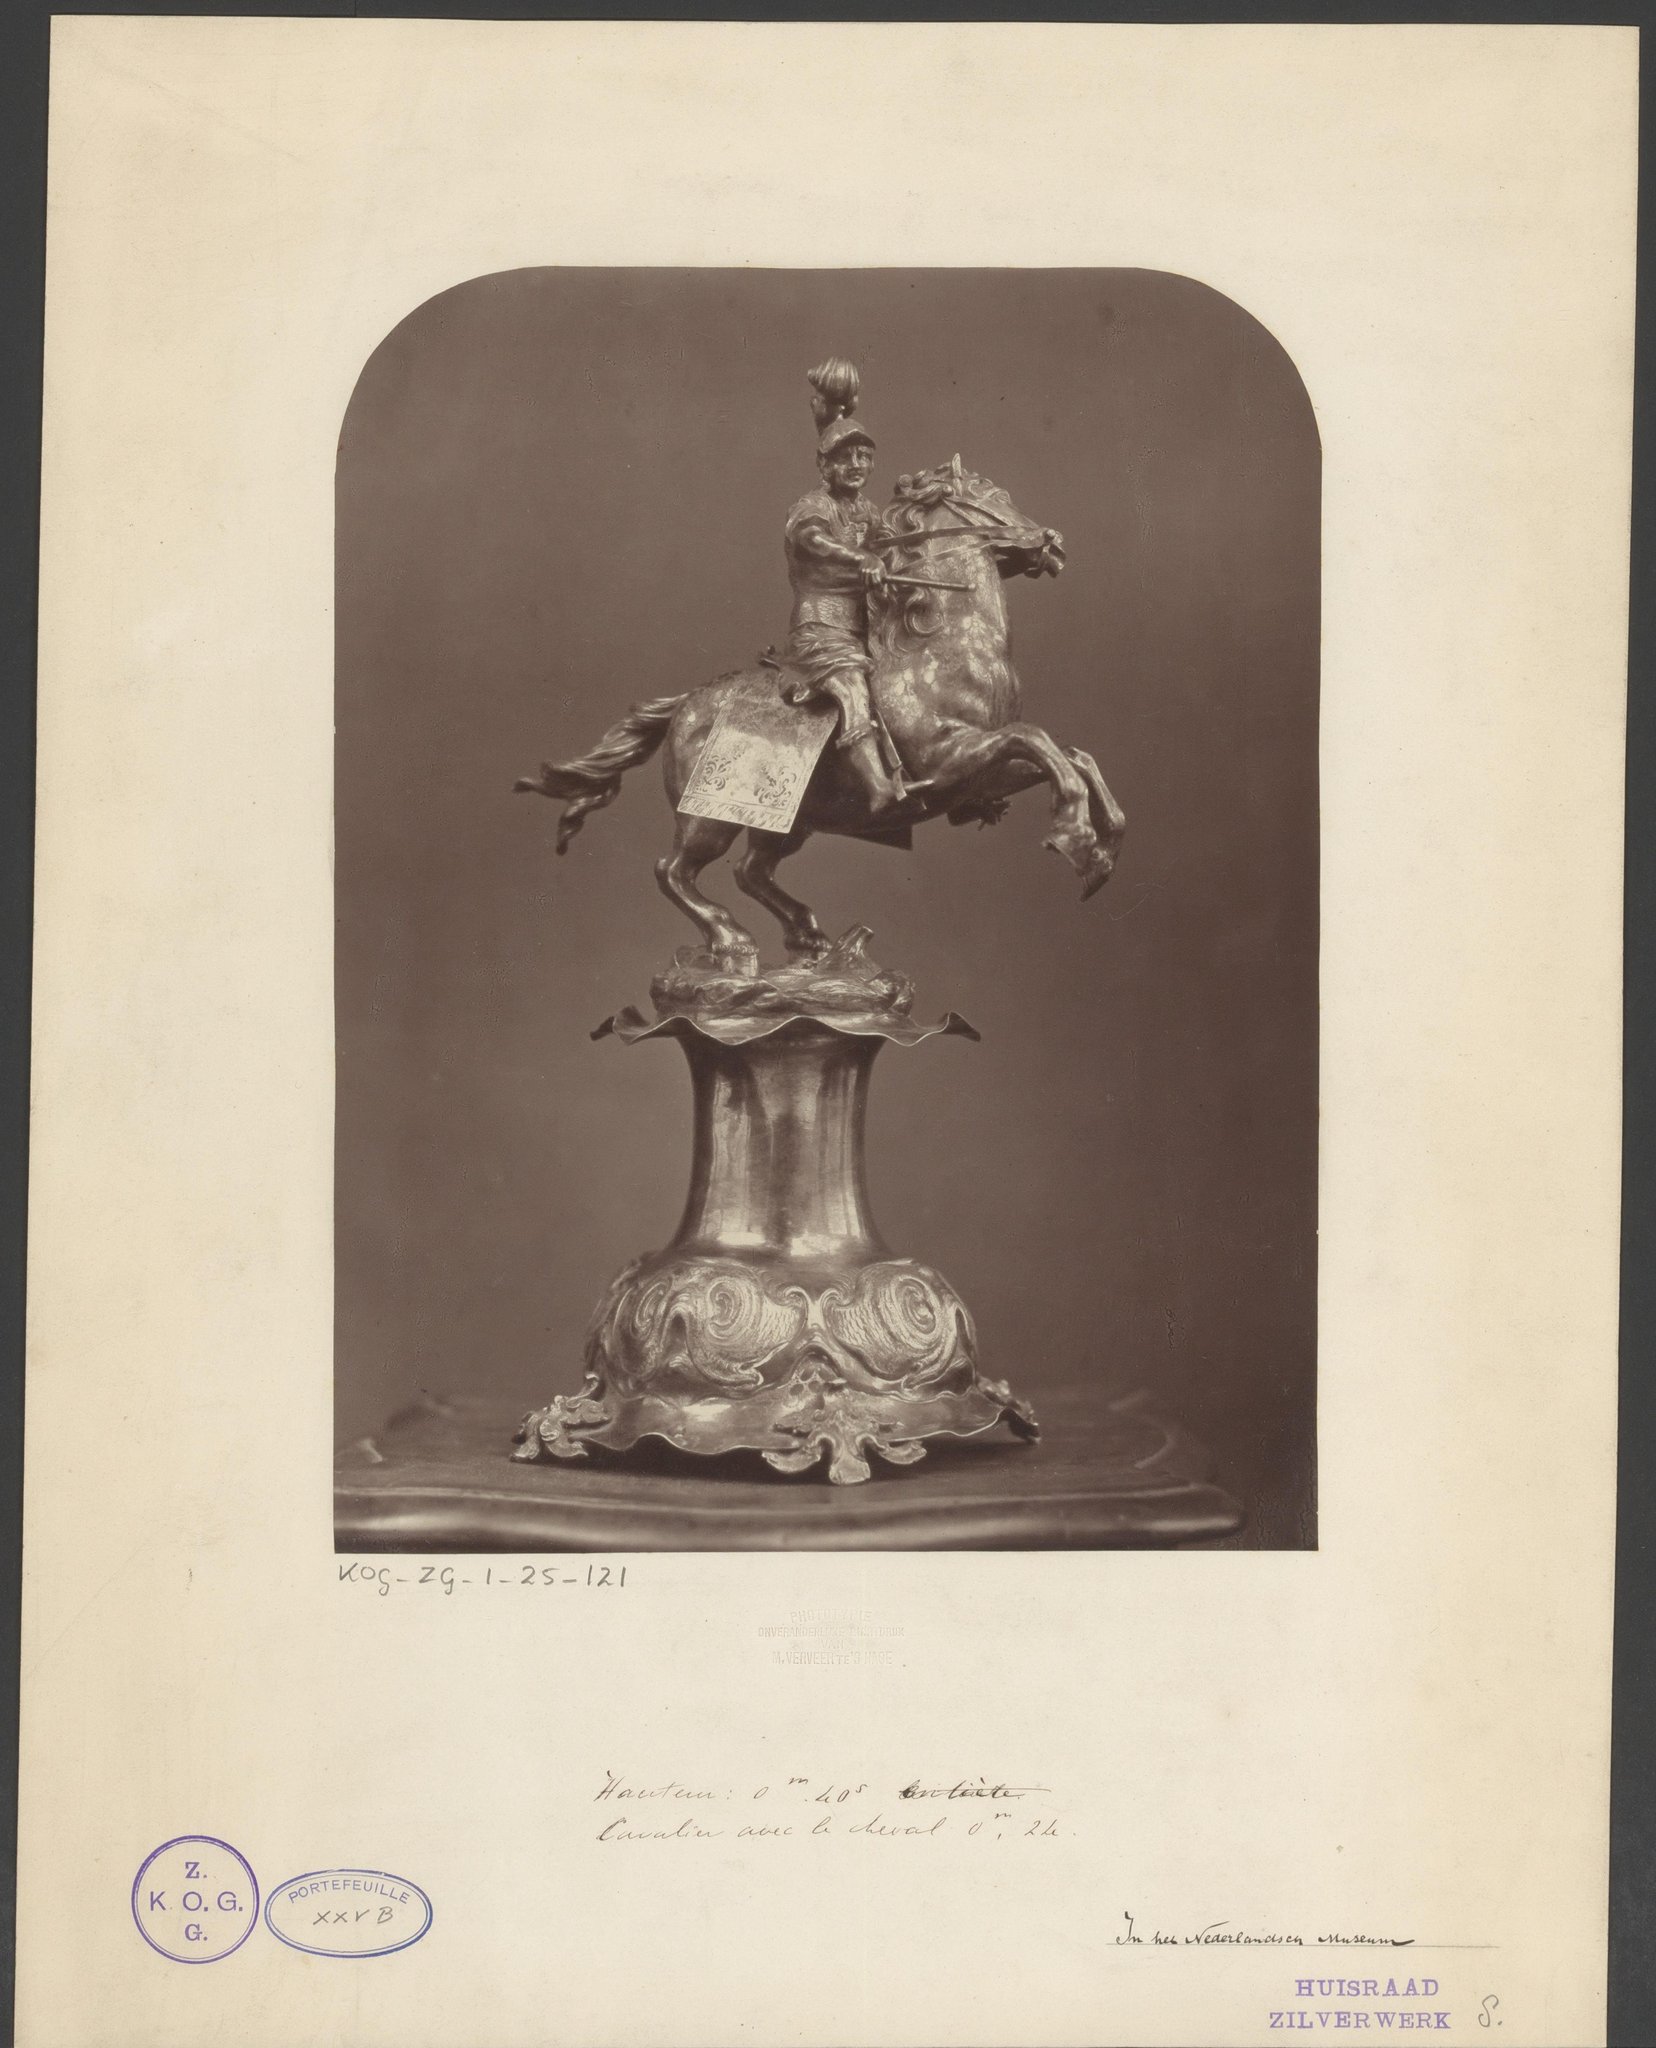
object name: photograph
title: Zilveren tafelstuk met ruiter te paard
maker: maurits verveer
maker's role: painter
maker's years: 1817-1903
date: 1857-1903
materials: paper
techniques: carbon print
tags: equestrian statue, dinner-service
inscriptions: check stamp: ‘Phototypie onveranderlijk lichtdruk van M. Verveer te 's Hage’, stamp, stamp, collector's mark: Lugt 1641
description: Onderwerpsrubrieken binnen de Atlas Zeden en Gewoonten: Zeden en Gewoonten in Engeren Zin, De Woning, Huisraad, Zilverwerk.